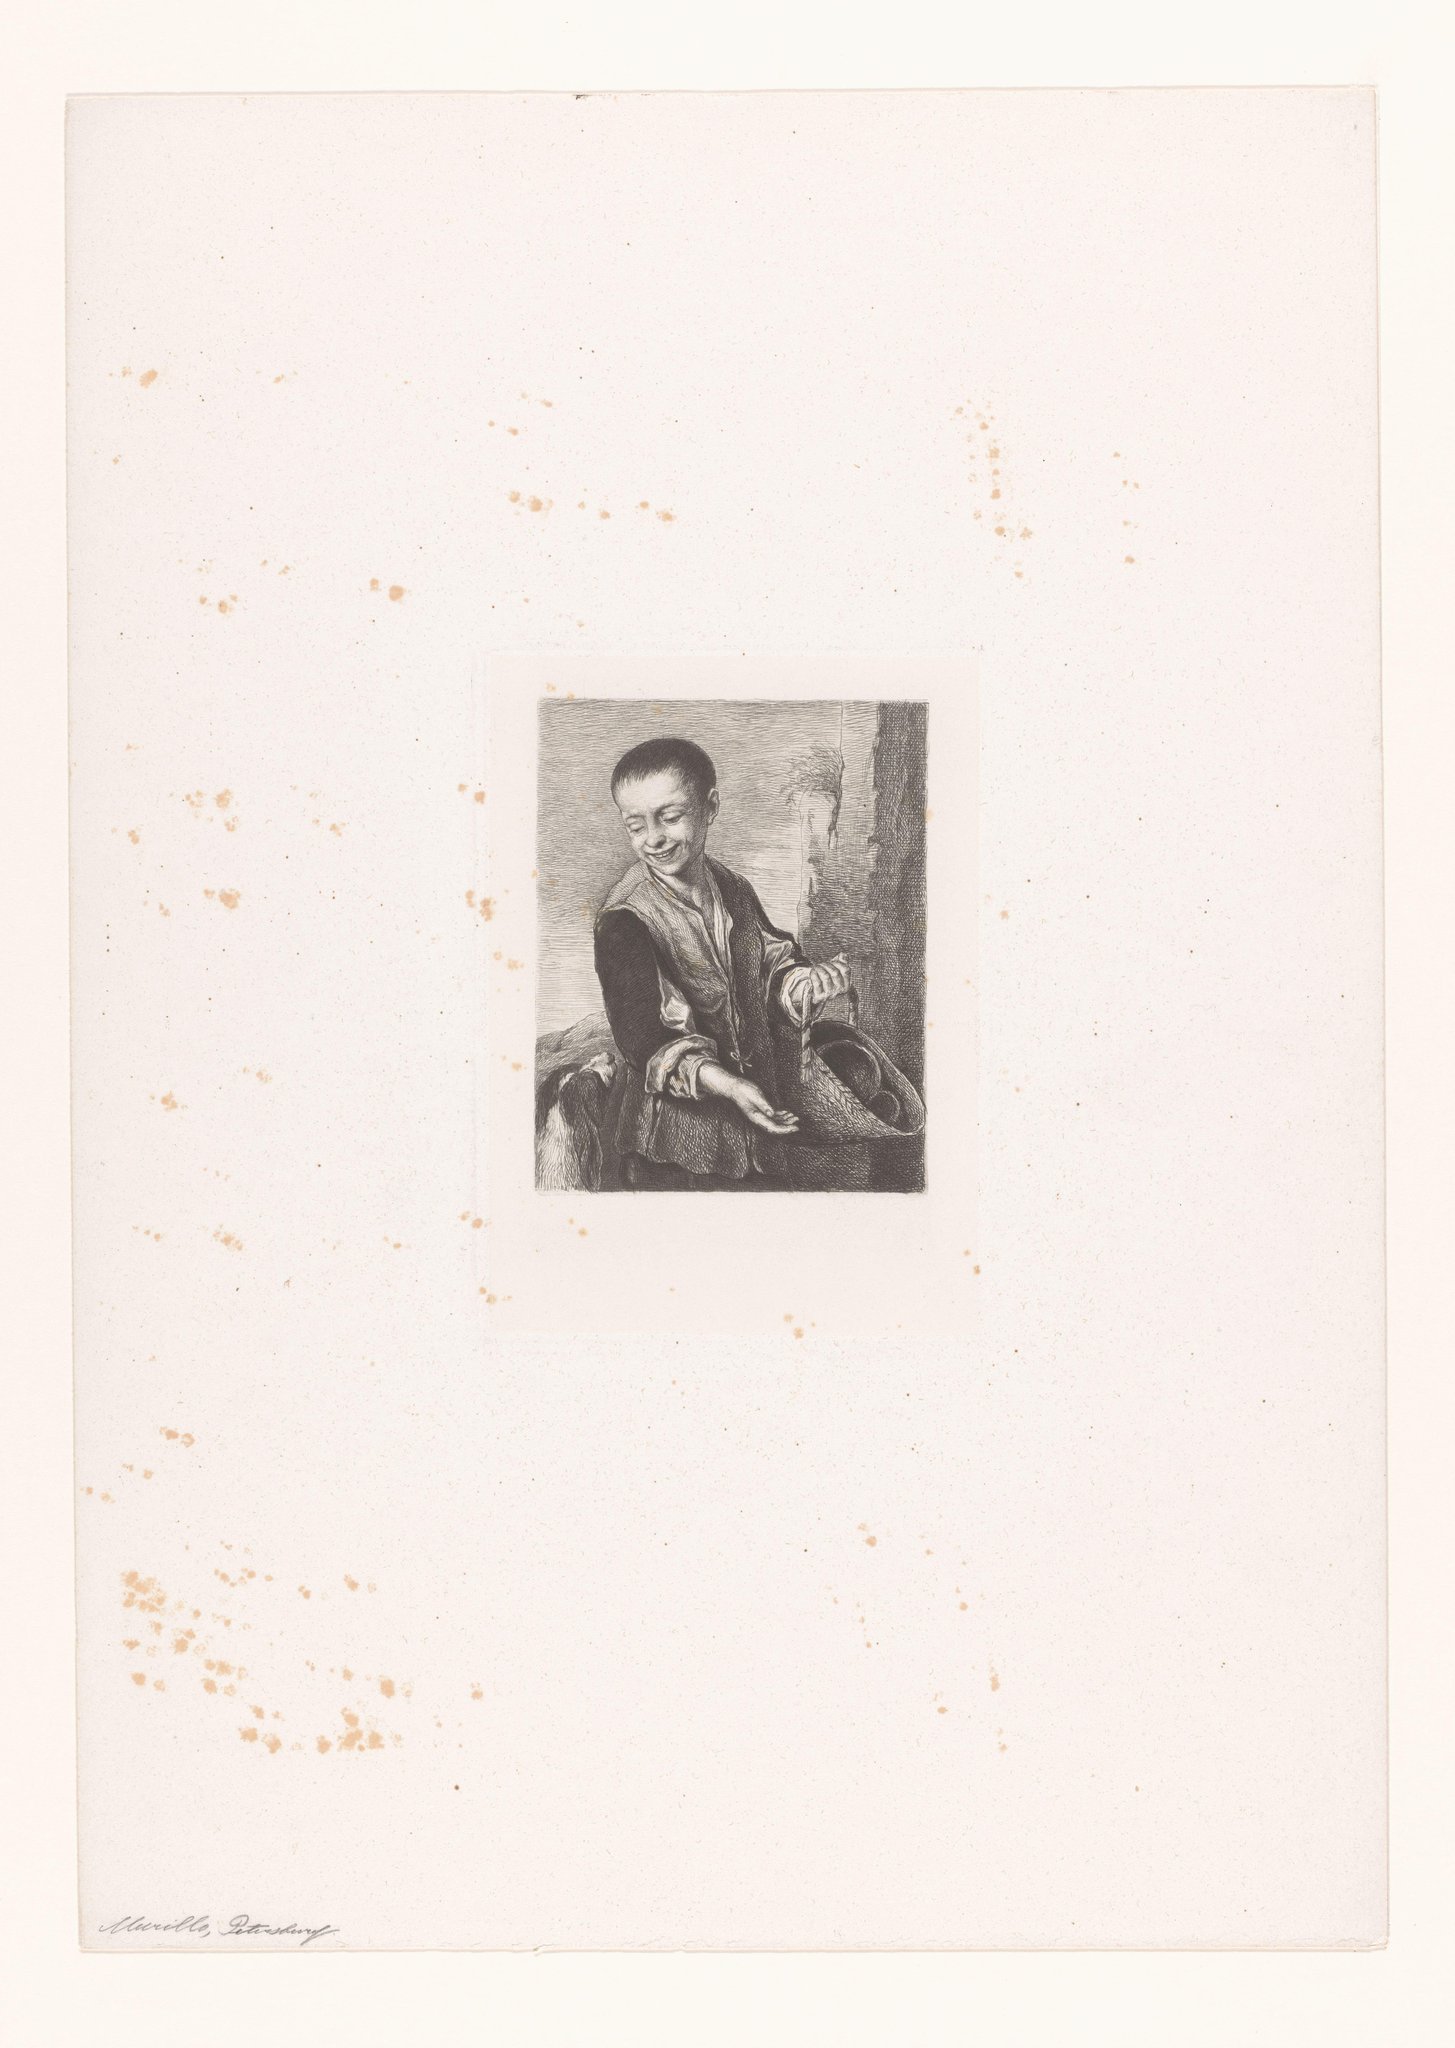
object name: print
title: Jongen met hond en mand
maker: nikolay semyonovich mosolov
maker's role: print maker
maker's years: 1847-1914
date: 1857-1914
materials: paper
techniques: drypoint, etching, intaglio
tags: boy (child between toddler and youth), dog